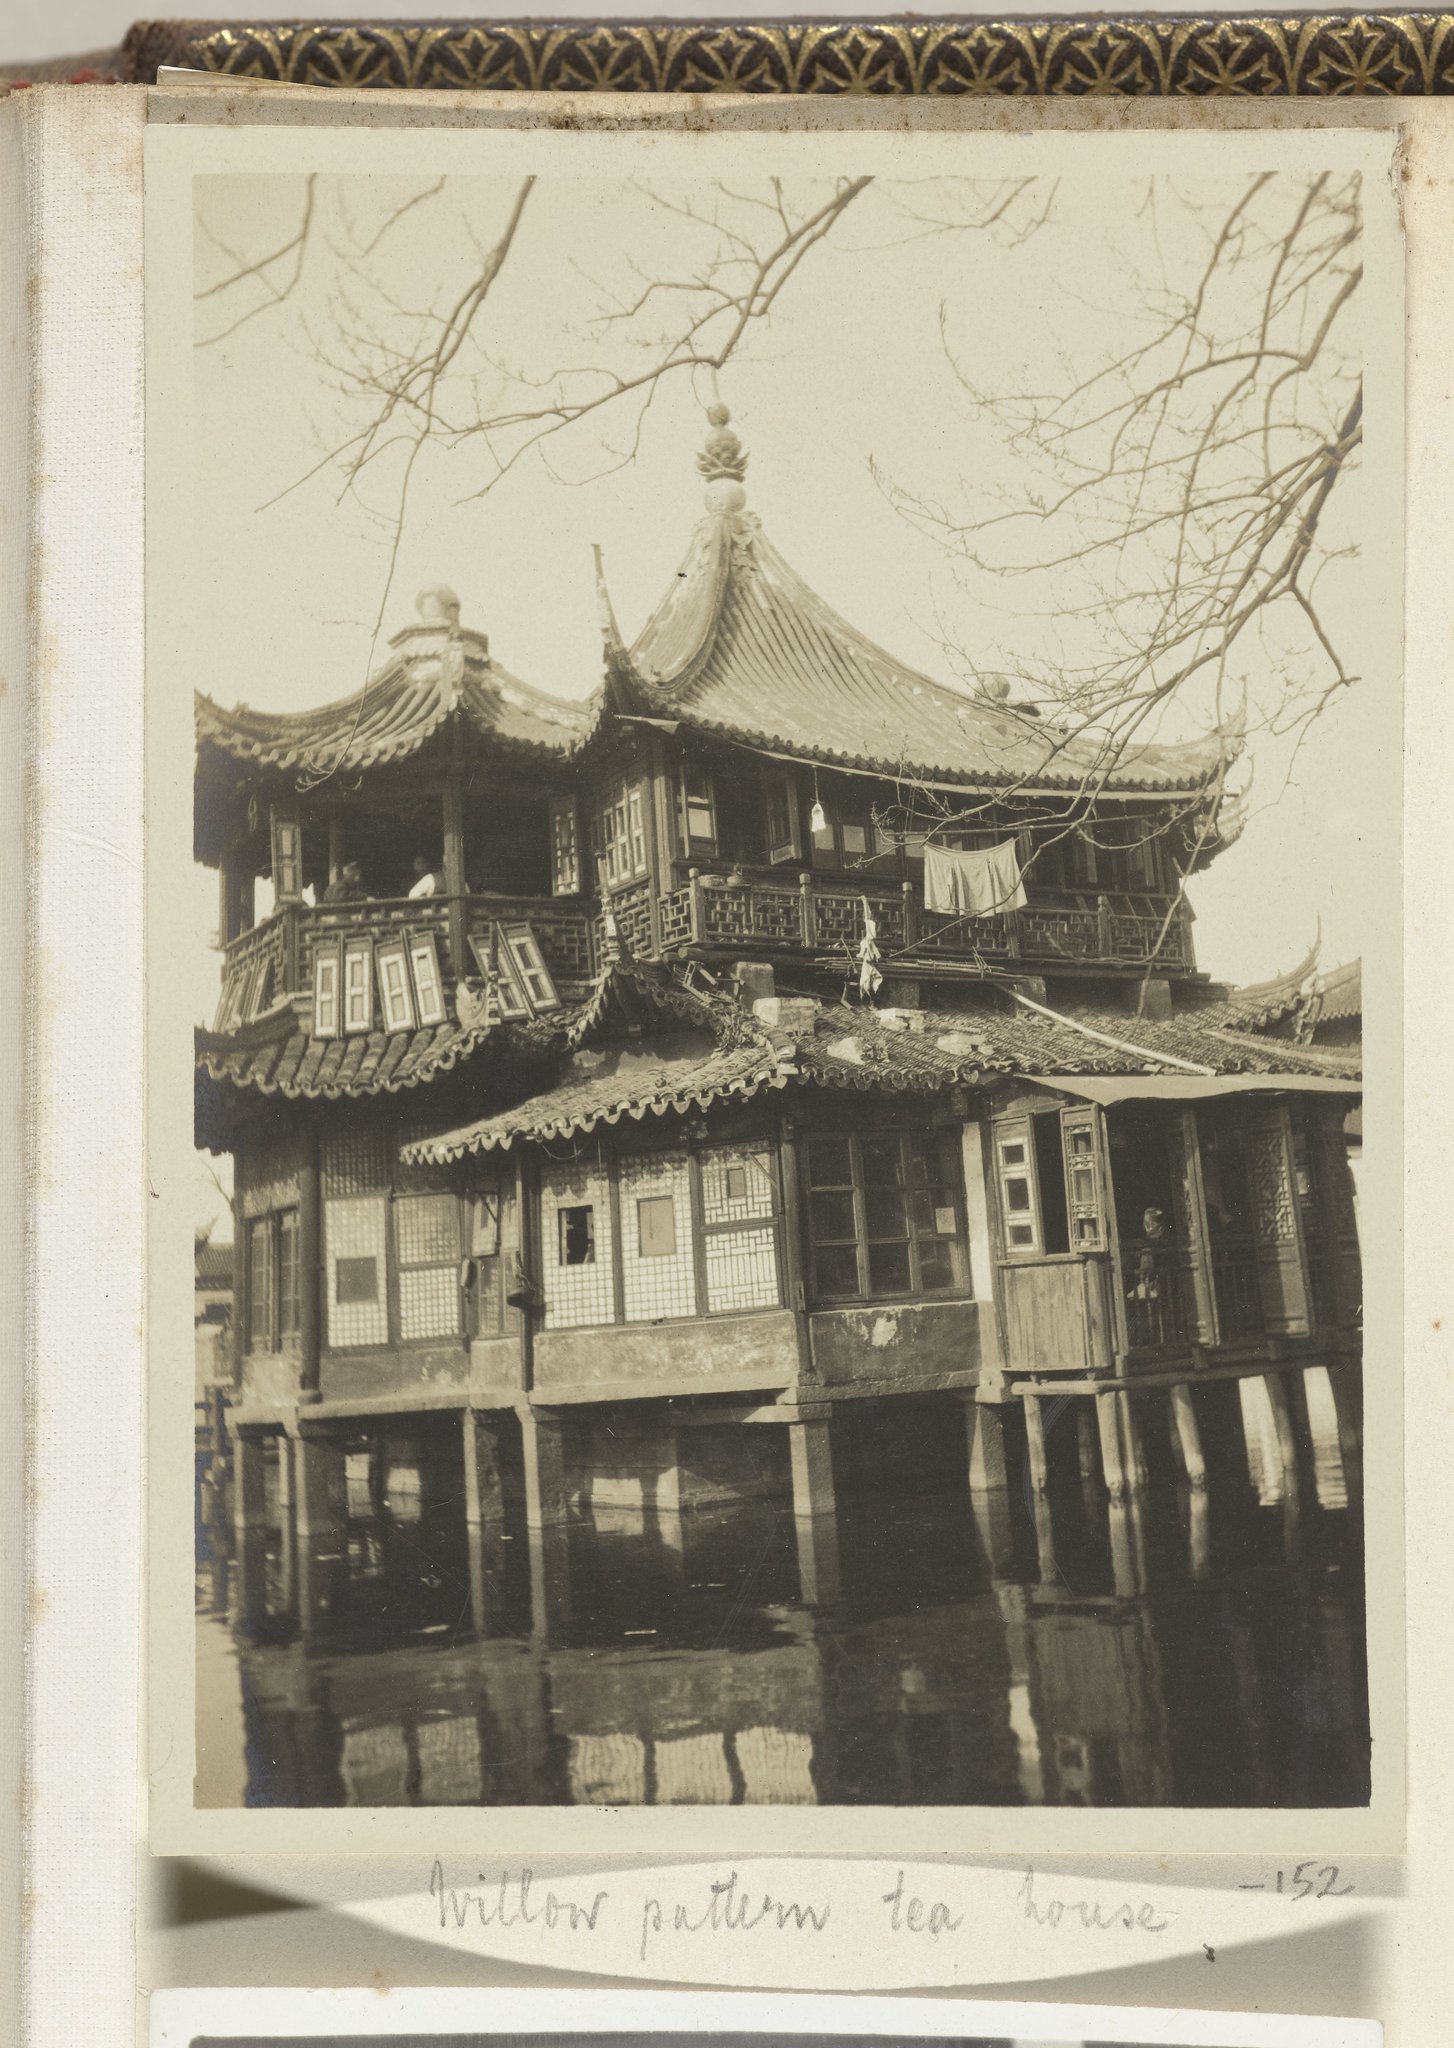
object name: photograph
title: Willow pattern tea house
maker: geldolph adriaan kessler (dolph)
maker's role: fotograaf, industrieel, voetballer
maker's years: 1884-1945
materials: cardboard, photographic support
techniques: gelatin silver print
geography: shanghai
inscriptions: title: ‘Willow pattern tea house’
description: Het Willow pattern teahouse in Shanghai. Onderdeel van het fotoalbum van Dolph Kessler met opnamen die hij maakte tijdens zijn verblijf in Engeland en op een wereldreis die hij als secretaris van Henri Deterding (directeur Koninklijke Olie) ondernam naar Nederlands-Indië, Japan, China en de Verenigde Staten, tussen 1906 en 1908.